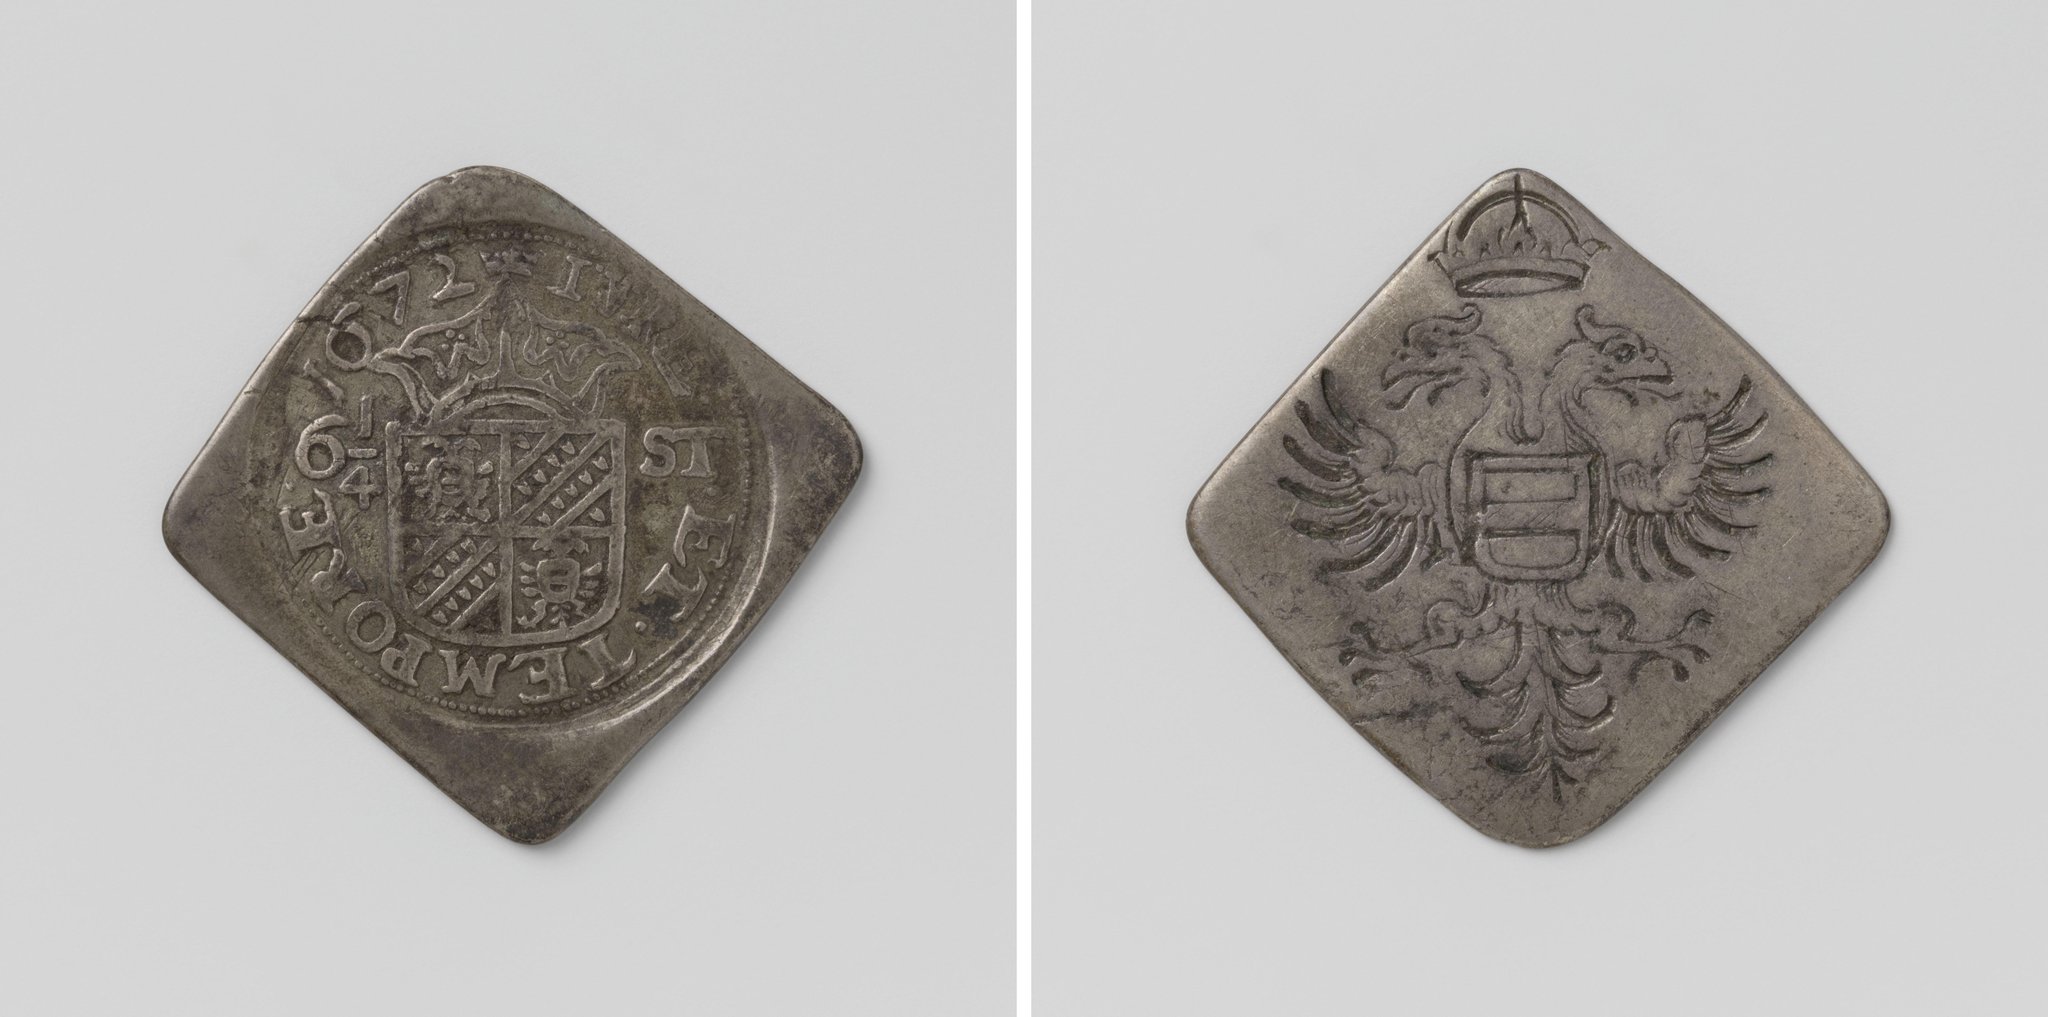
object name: siege coin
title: Achtste daalder; noodmunt uit Groningen, geslagen tijdens het beleg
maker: Anonymous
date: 1672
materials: silver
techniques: striking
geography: groningen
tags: groningen, beleg van groningen (1672)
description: Achtste daalder uit Groningen; ruitvormige noodmunt met afgeronde hoeken. Voorzijde: gekroond wapenschild tussen waardeaanduiding binnen omschrift. Keerzijde: gekroonde, dubbelkoppige adelaar